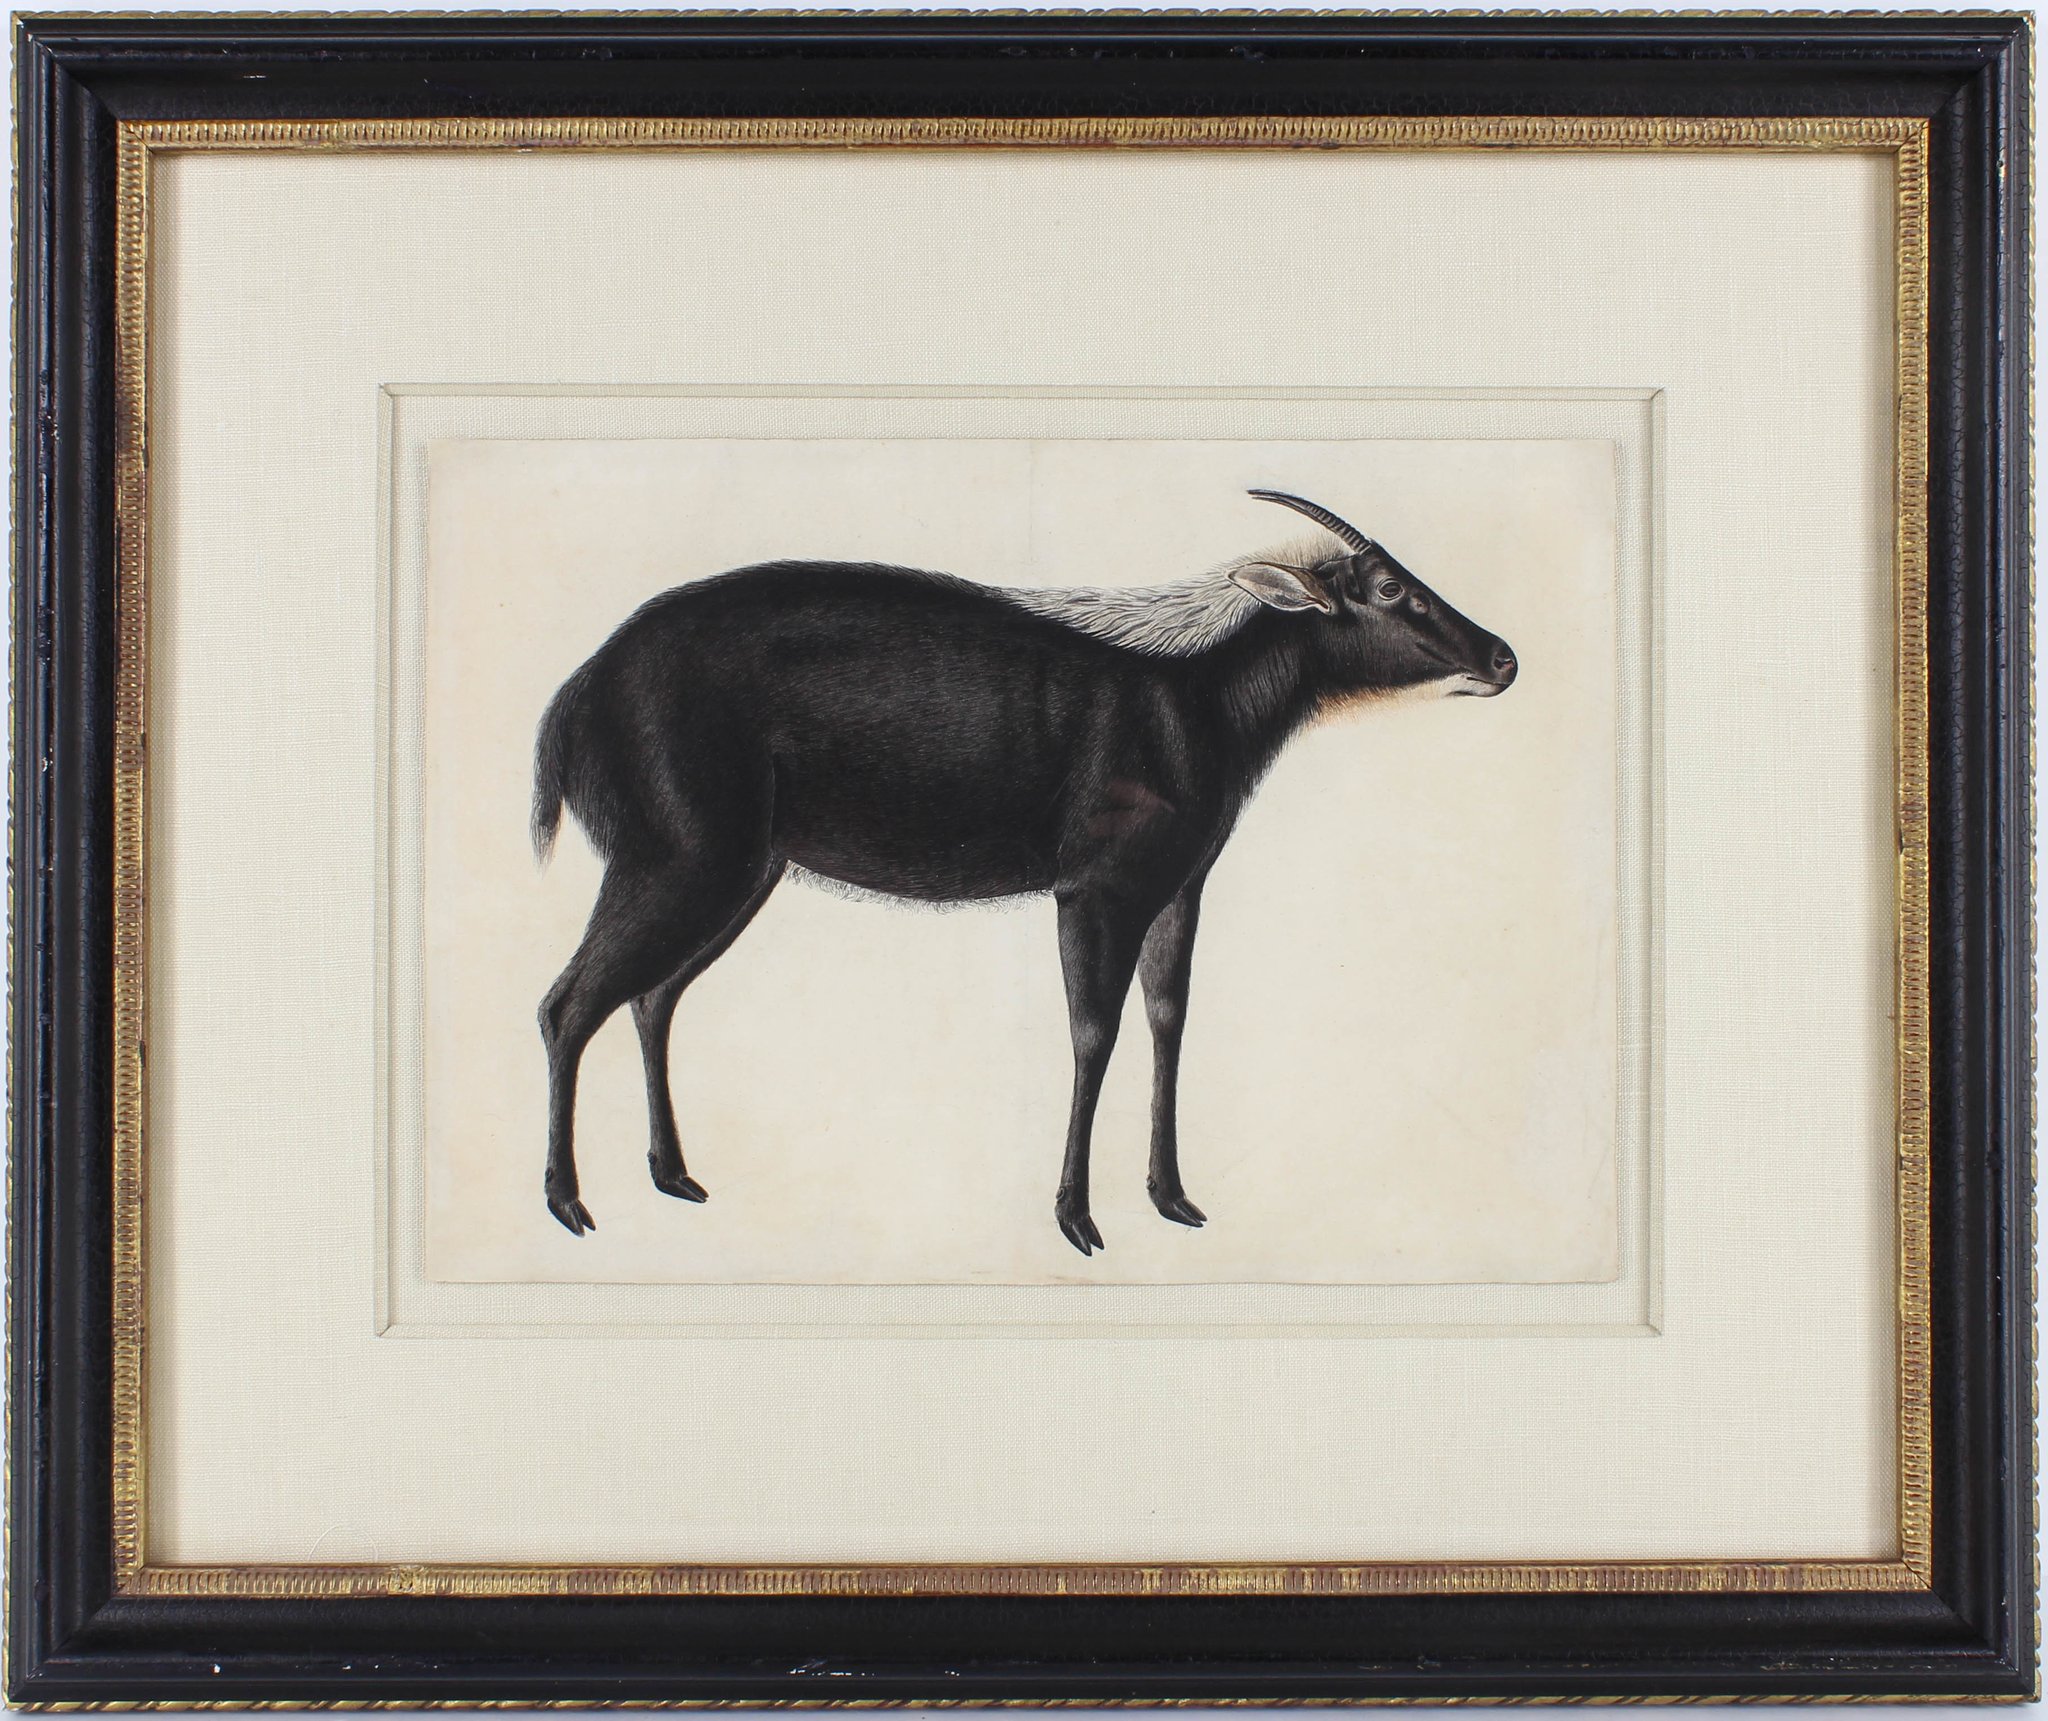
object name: illustrated single work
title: A Chinese Serow (Capricornis milneedwardsi argyrochaetes)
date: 1800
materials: ink, paper, watercolor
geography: india